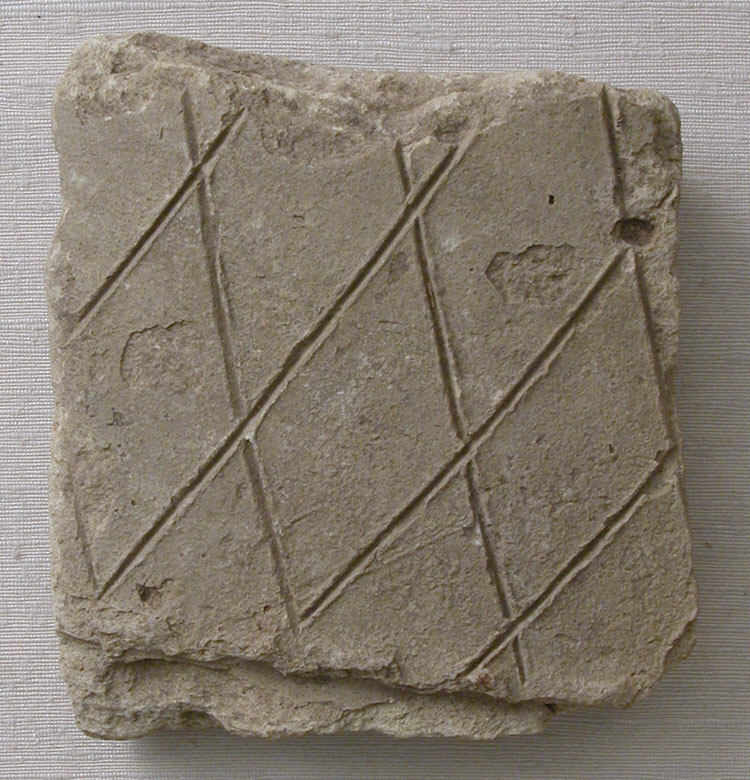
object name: fragment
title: Ceramic Fragment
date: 701-900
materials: earthenware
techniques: incising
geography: iraq